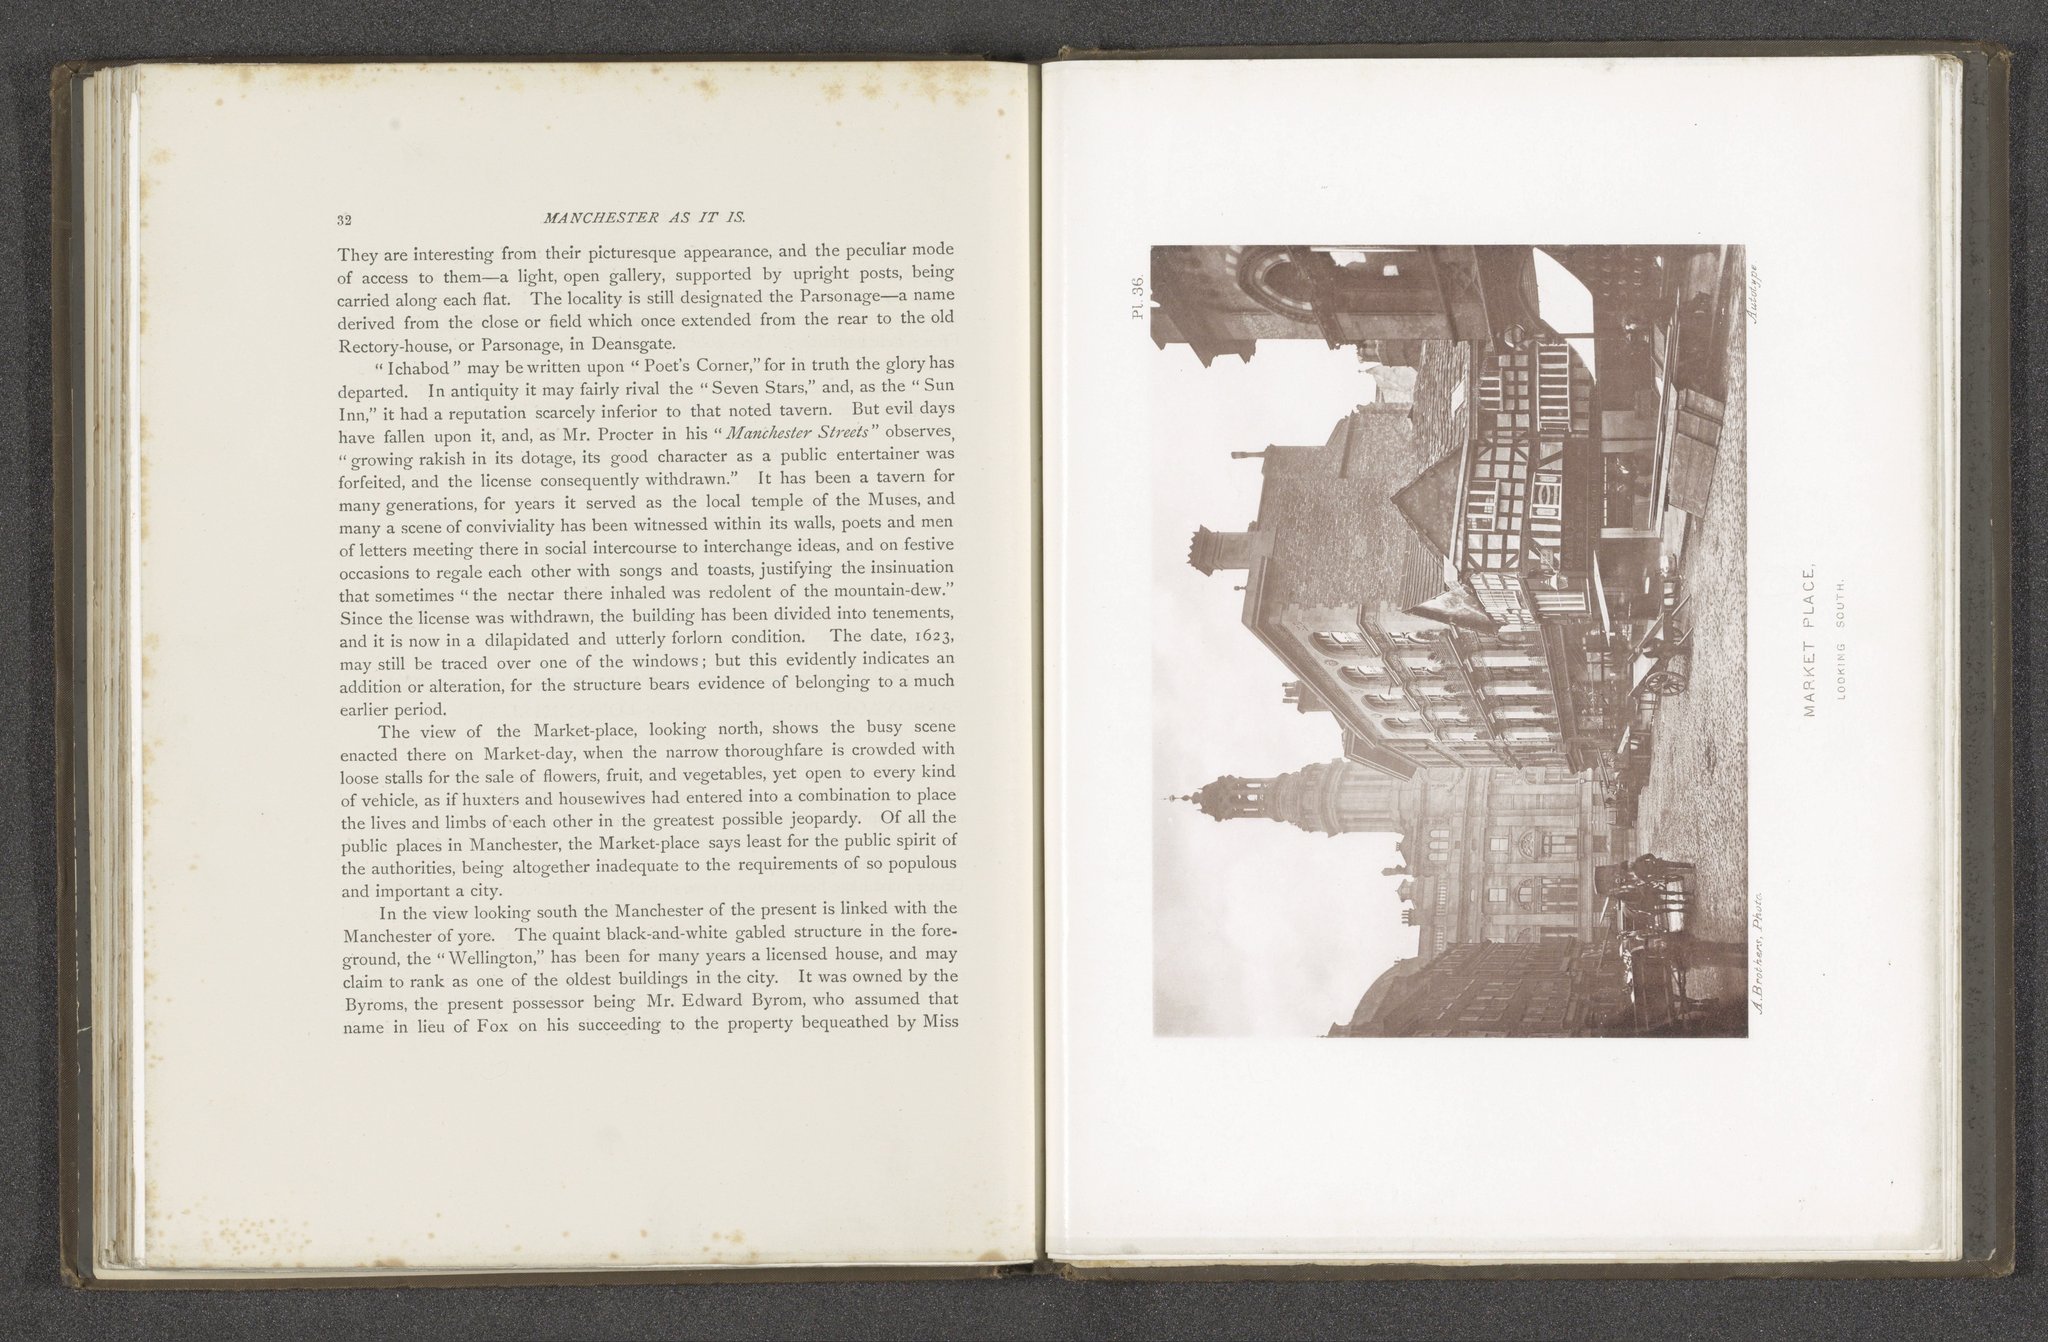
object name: photomechanical print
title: Market Place, looking south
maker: Anonymous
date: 1868-1878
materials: paper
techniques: photograph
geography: manchester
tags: hand-cart, tower, clock tower ~ monumental adornment, market, manchester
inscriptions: number: ‘Pl. 36.’